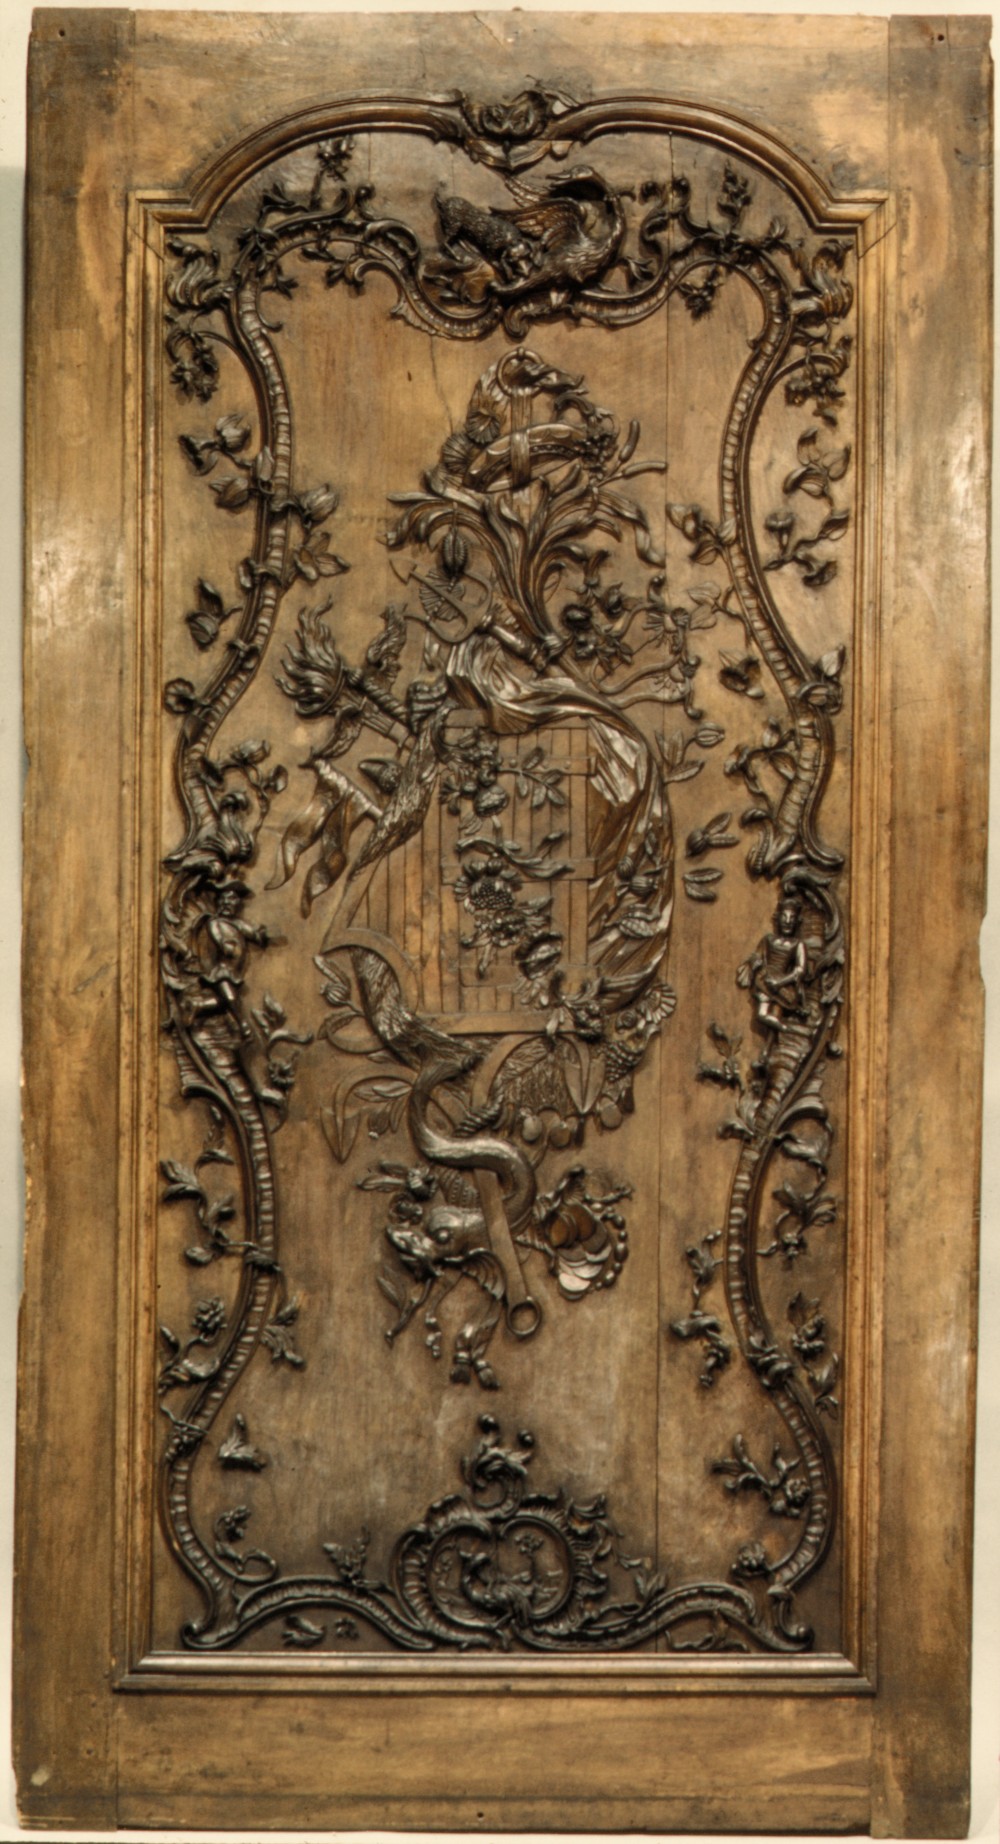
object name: door panel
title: Door panel (?)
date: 1726-1750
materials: wood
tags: animals,birds,men,flowers